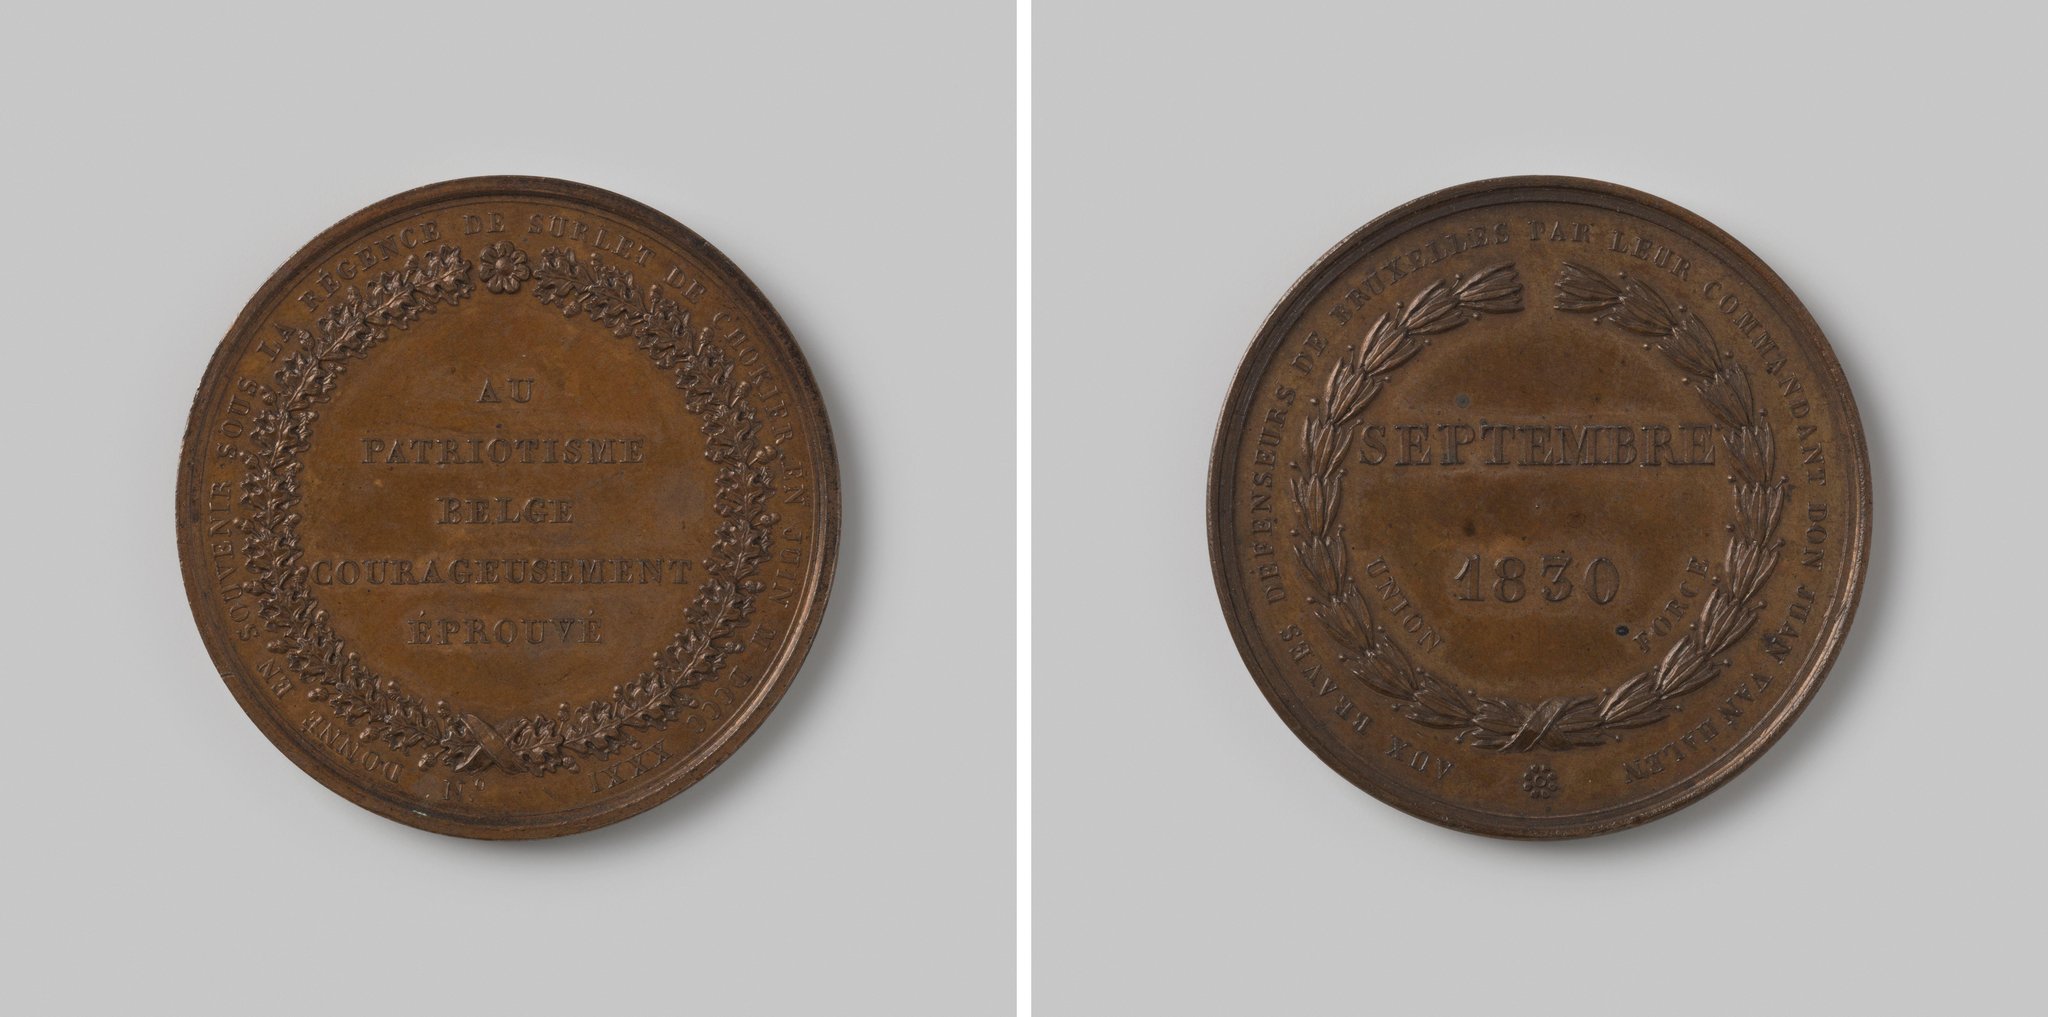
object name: history medal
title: Installatie van het Voorlopig Bewind van België 1830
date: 1830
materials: bronze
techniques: striking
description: Bronzen penning, op de voorzijde vijf regels tekst binnen een eikenkrans, met omschrift, op de keerzijde drie regels tekst binnen een lauwerkrans, met omschrift.